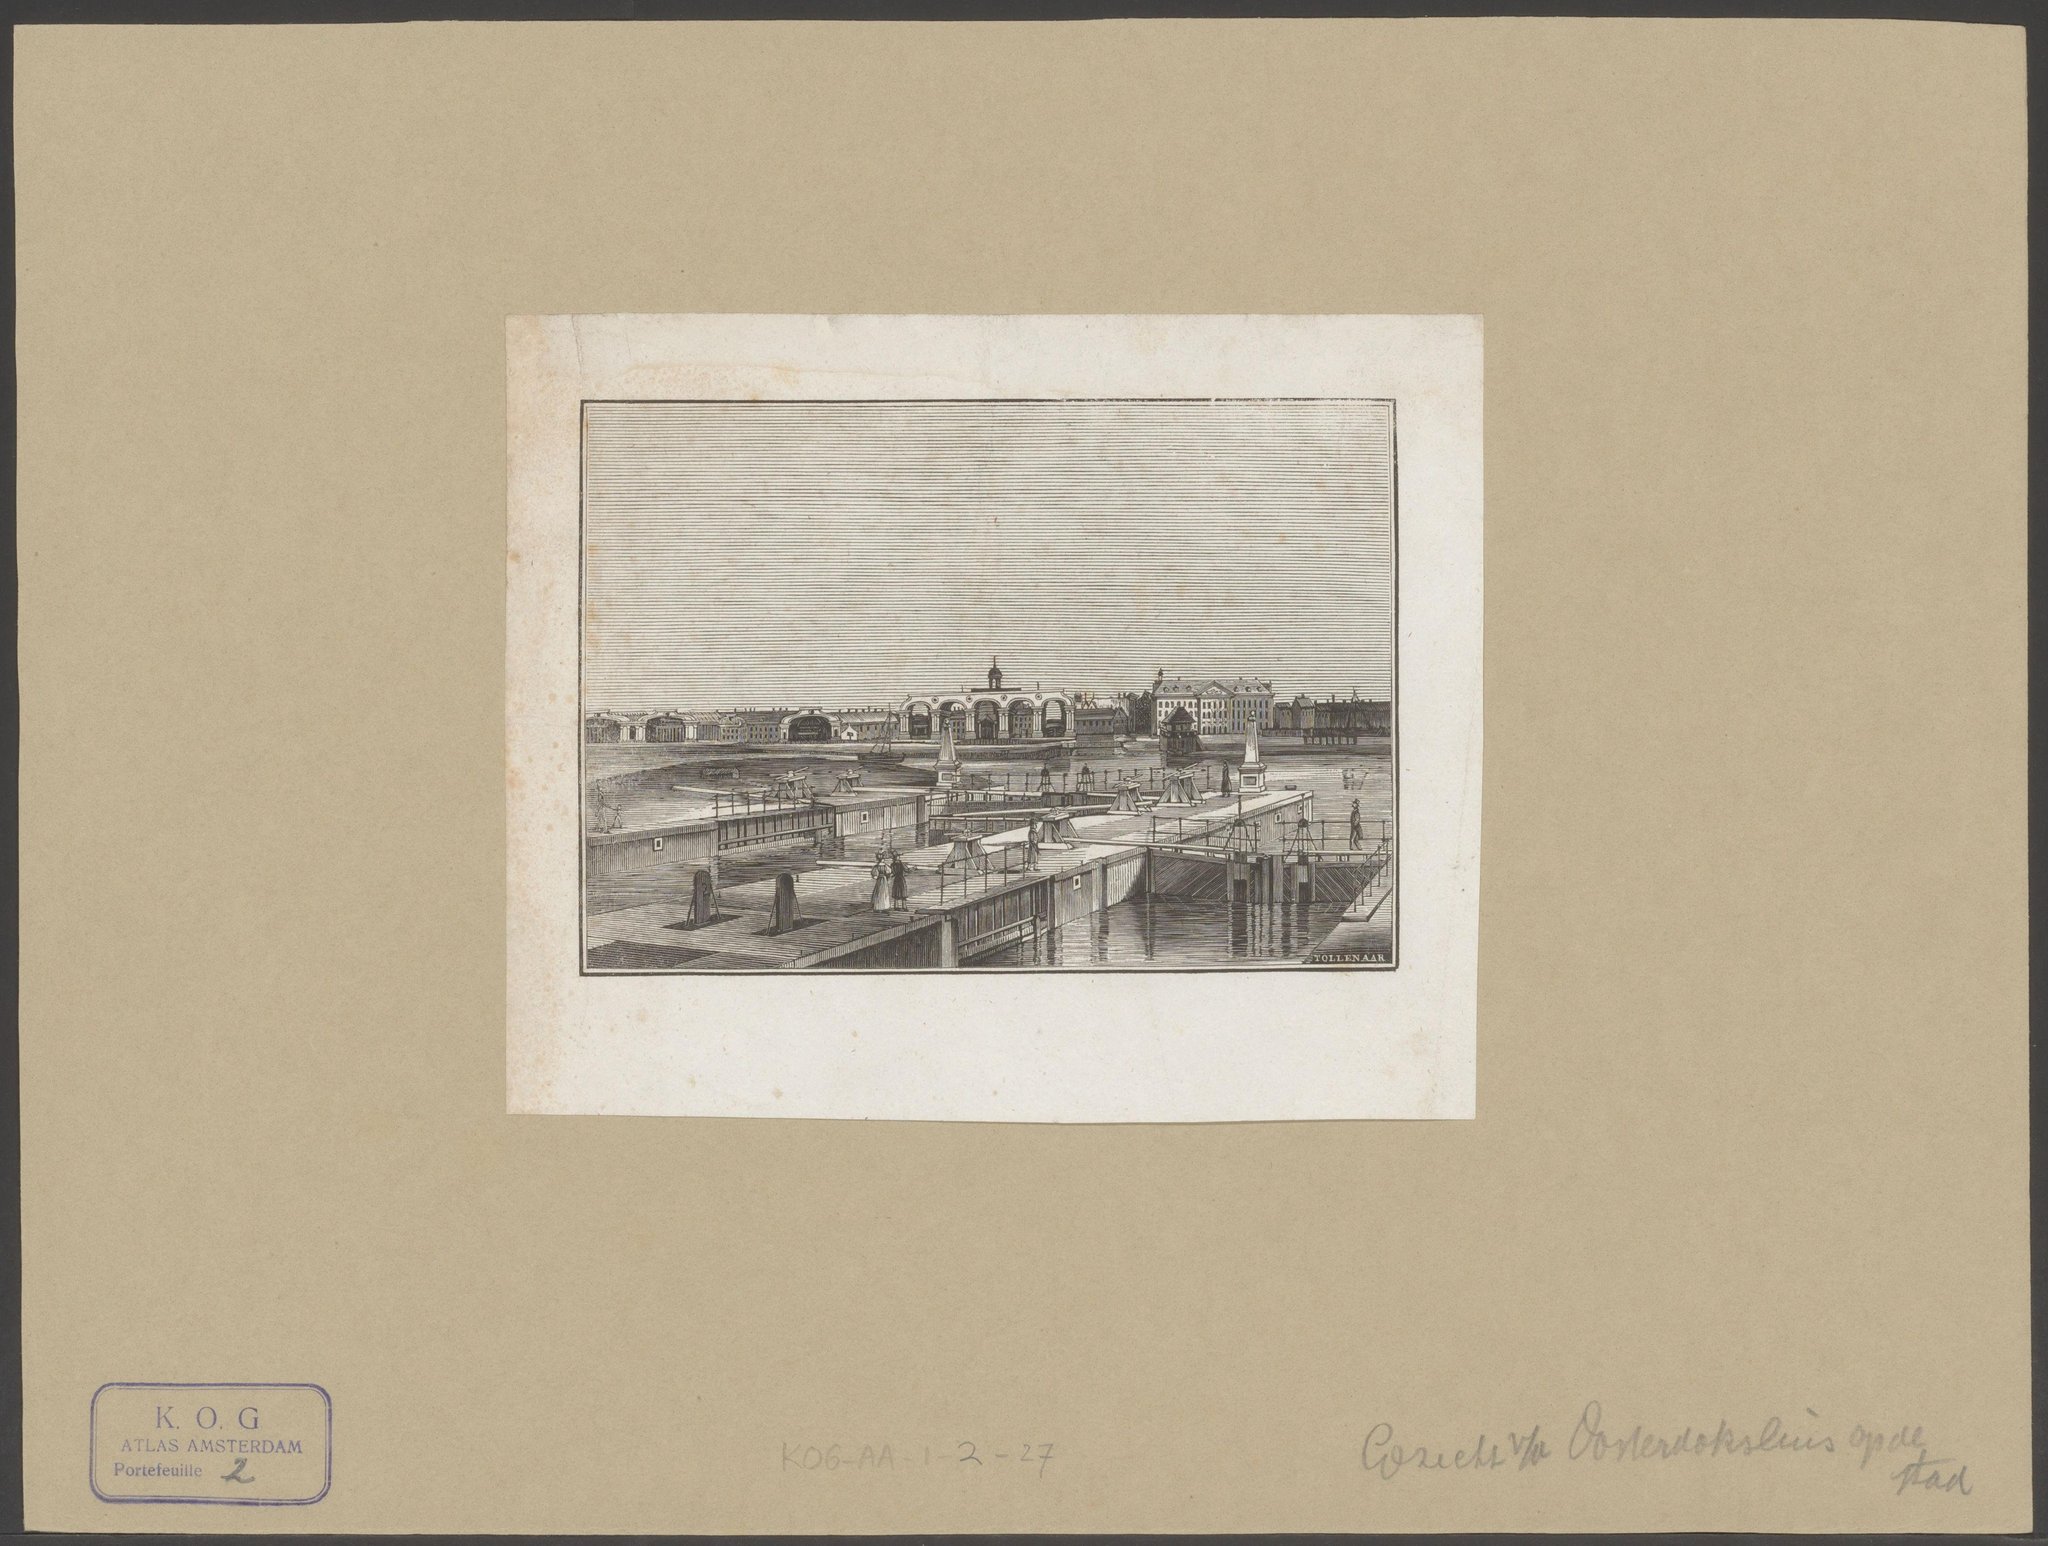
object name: print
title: Gezicht vanaf de Oosterdokssluis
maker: Anonymous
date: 1800-1899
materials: paper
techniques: engraving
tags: sluice, weir, city-view in general; 'veduta', river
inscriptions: name: ‘Tollenaar’, inscription: ‘Gezicht v/d Oosterdoksluis op de / stad’, collector's mark: ‘2’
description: Onderwerpsrubriek binnen de Atlas Amsterdam: Gezichten van het IJ op het Oostelijk gedeelte der stad, Nieuwebrug tot Zeeburg.